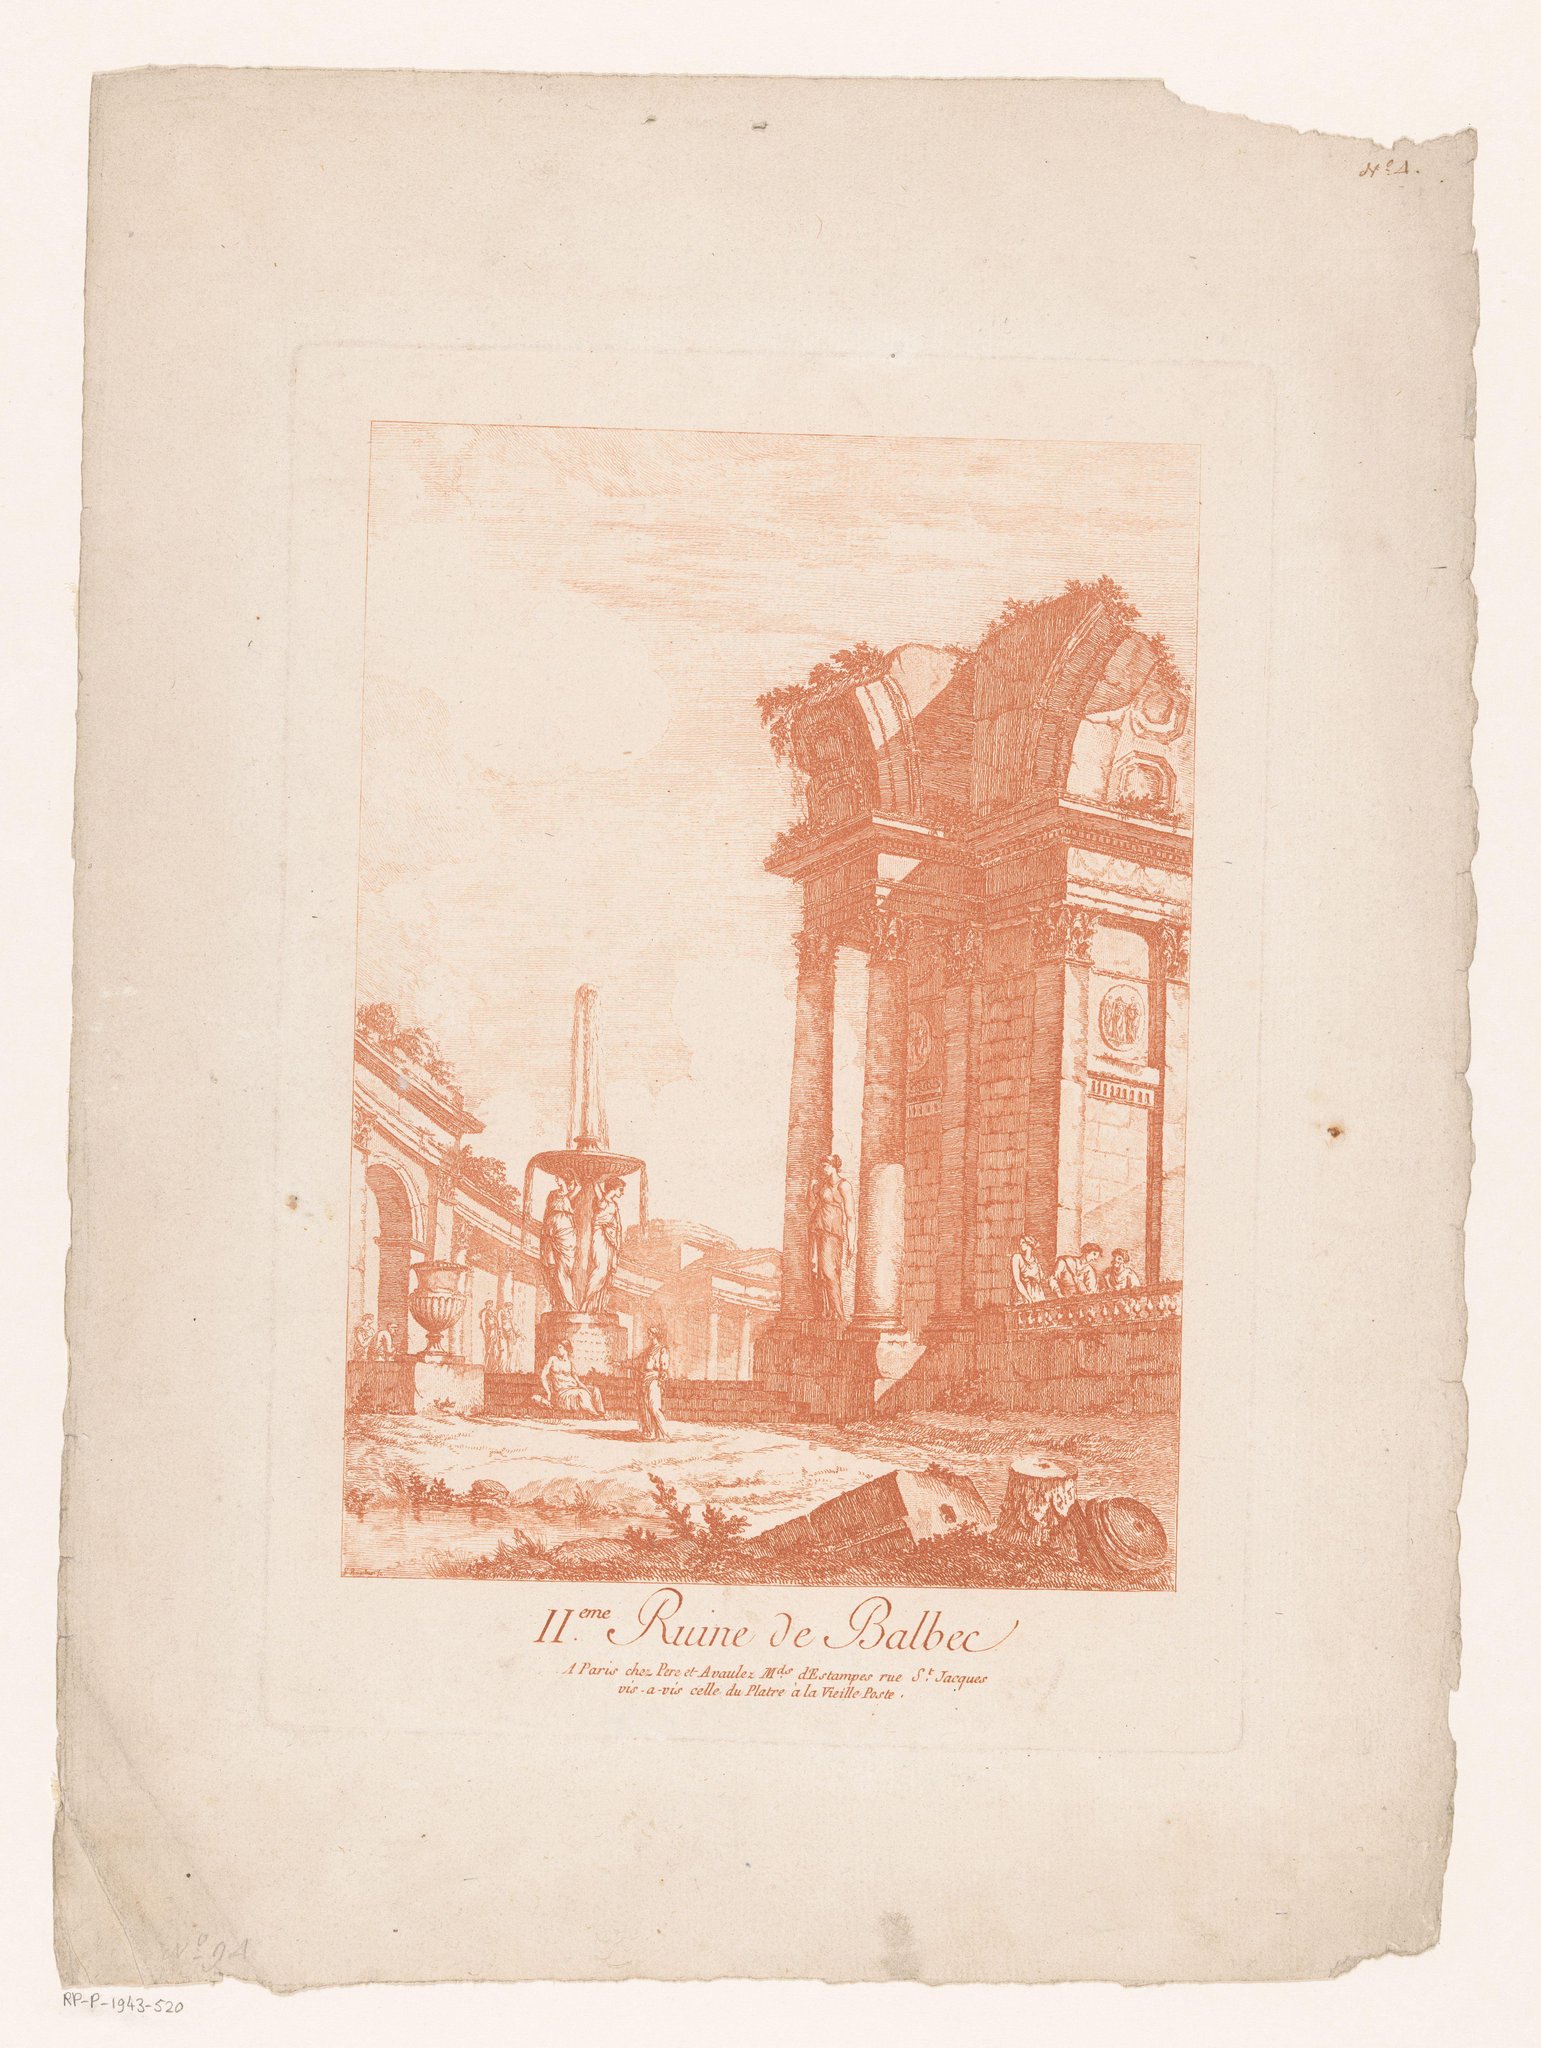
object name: print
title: 2e Ruine de Balbec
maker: juste nathan françois boucher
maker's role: print maker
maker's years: 1736-1782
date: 1772-1779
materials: paper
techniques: etching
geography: paris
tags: ruin of a dwelling, house, castle, etc.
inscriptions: collector's mark: Lugt 2228